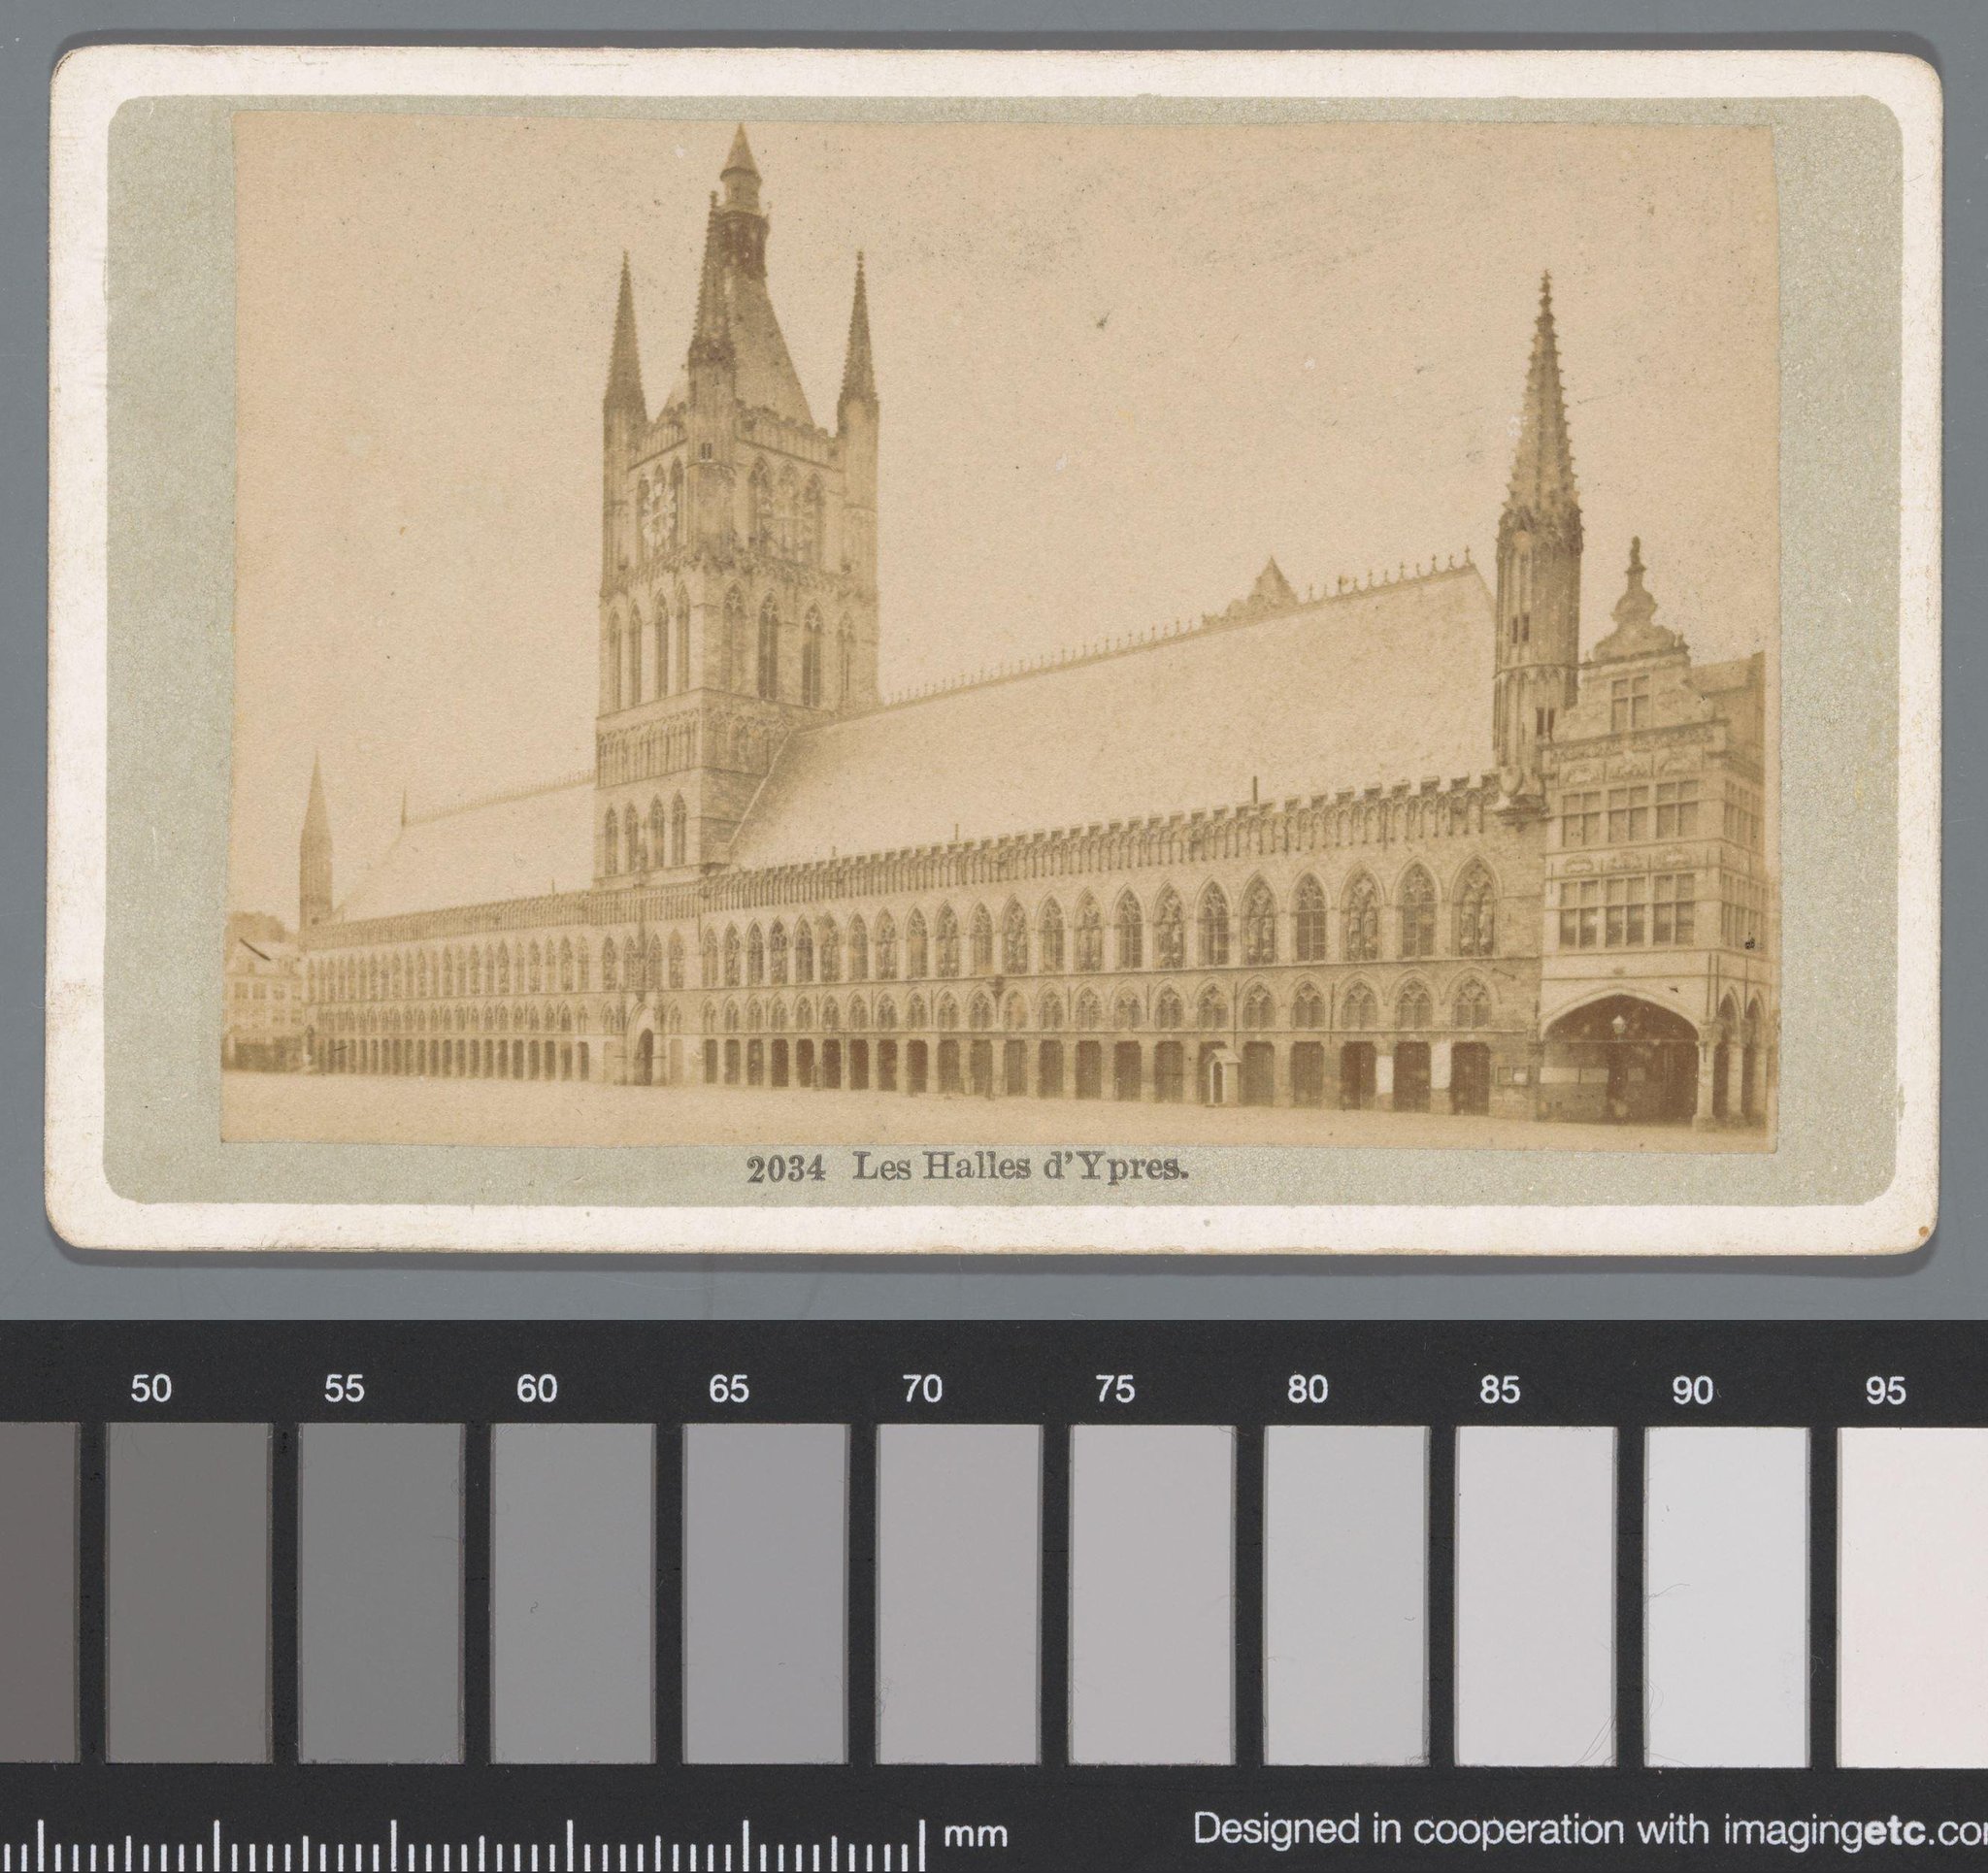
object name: photograph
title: Lakenhalle van Ieper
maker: Anonymous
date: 1855-1885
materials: cardboard, paper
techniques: albumen print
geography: ieper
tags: edifice, e.g.: public building, department store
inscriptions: number: ‘2034’